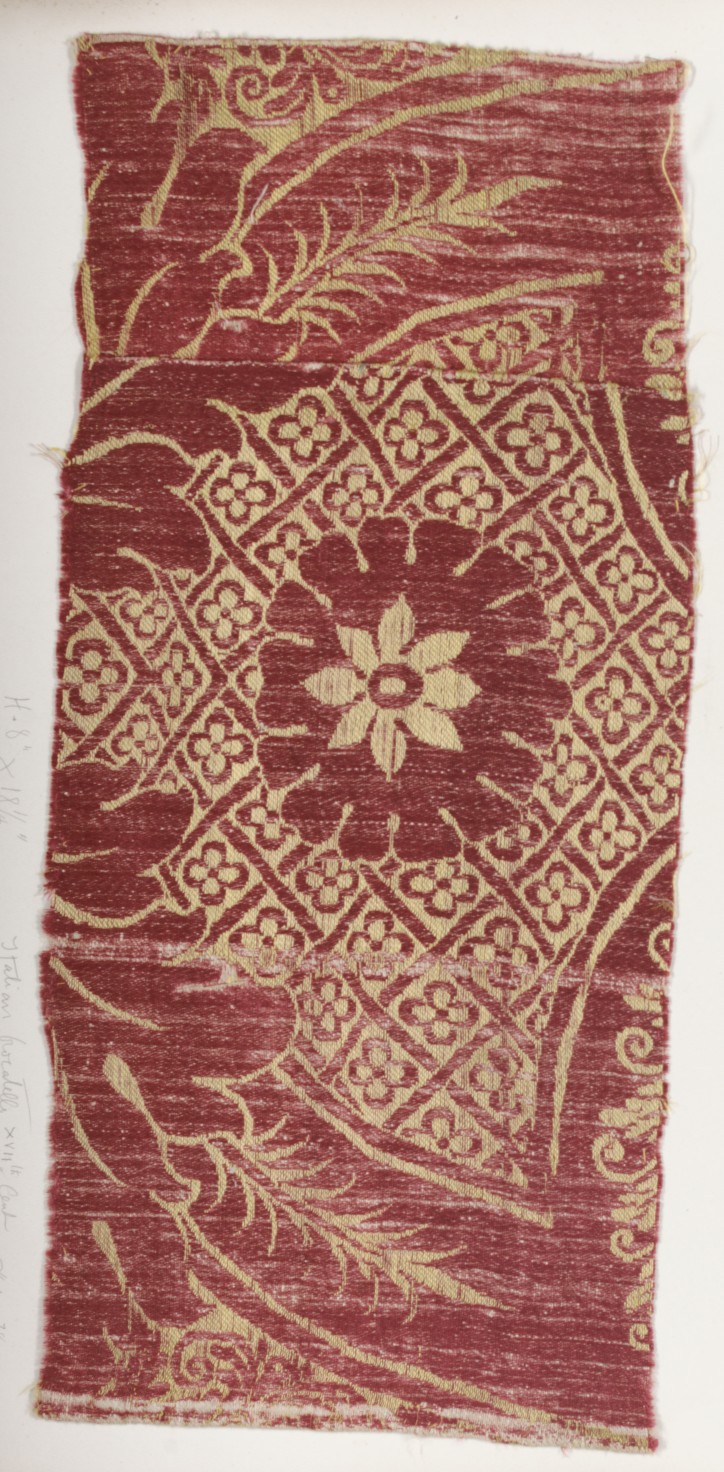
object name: fragment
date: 1601-1700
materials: silk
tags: flowers